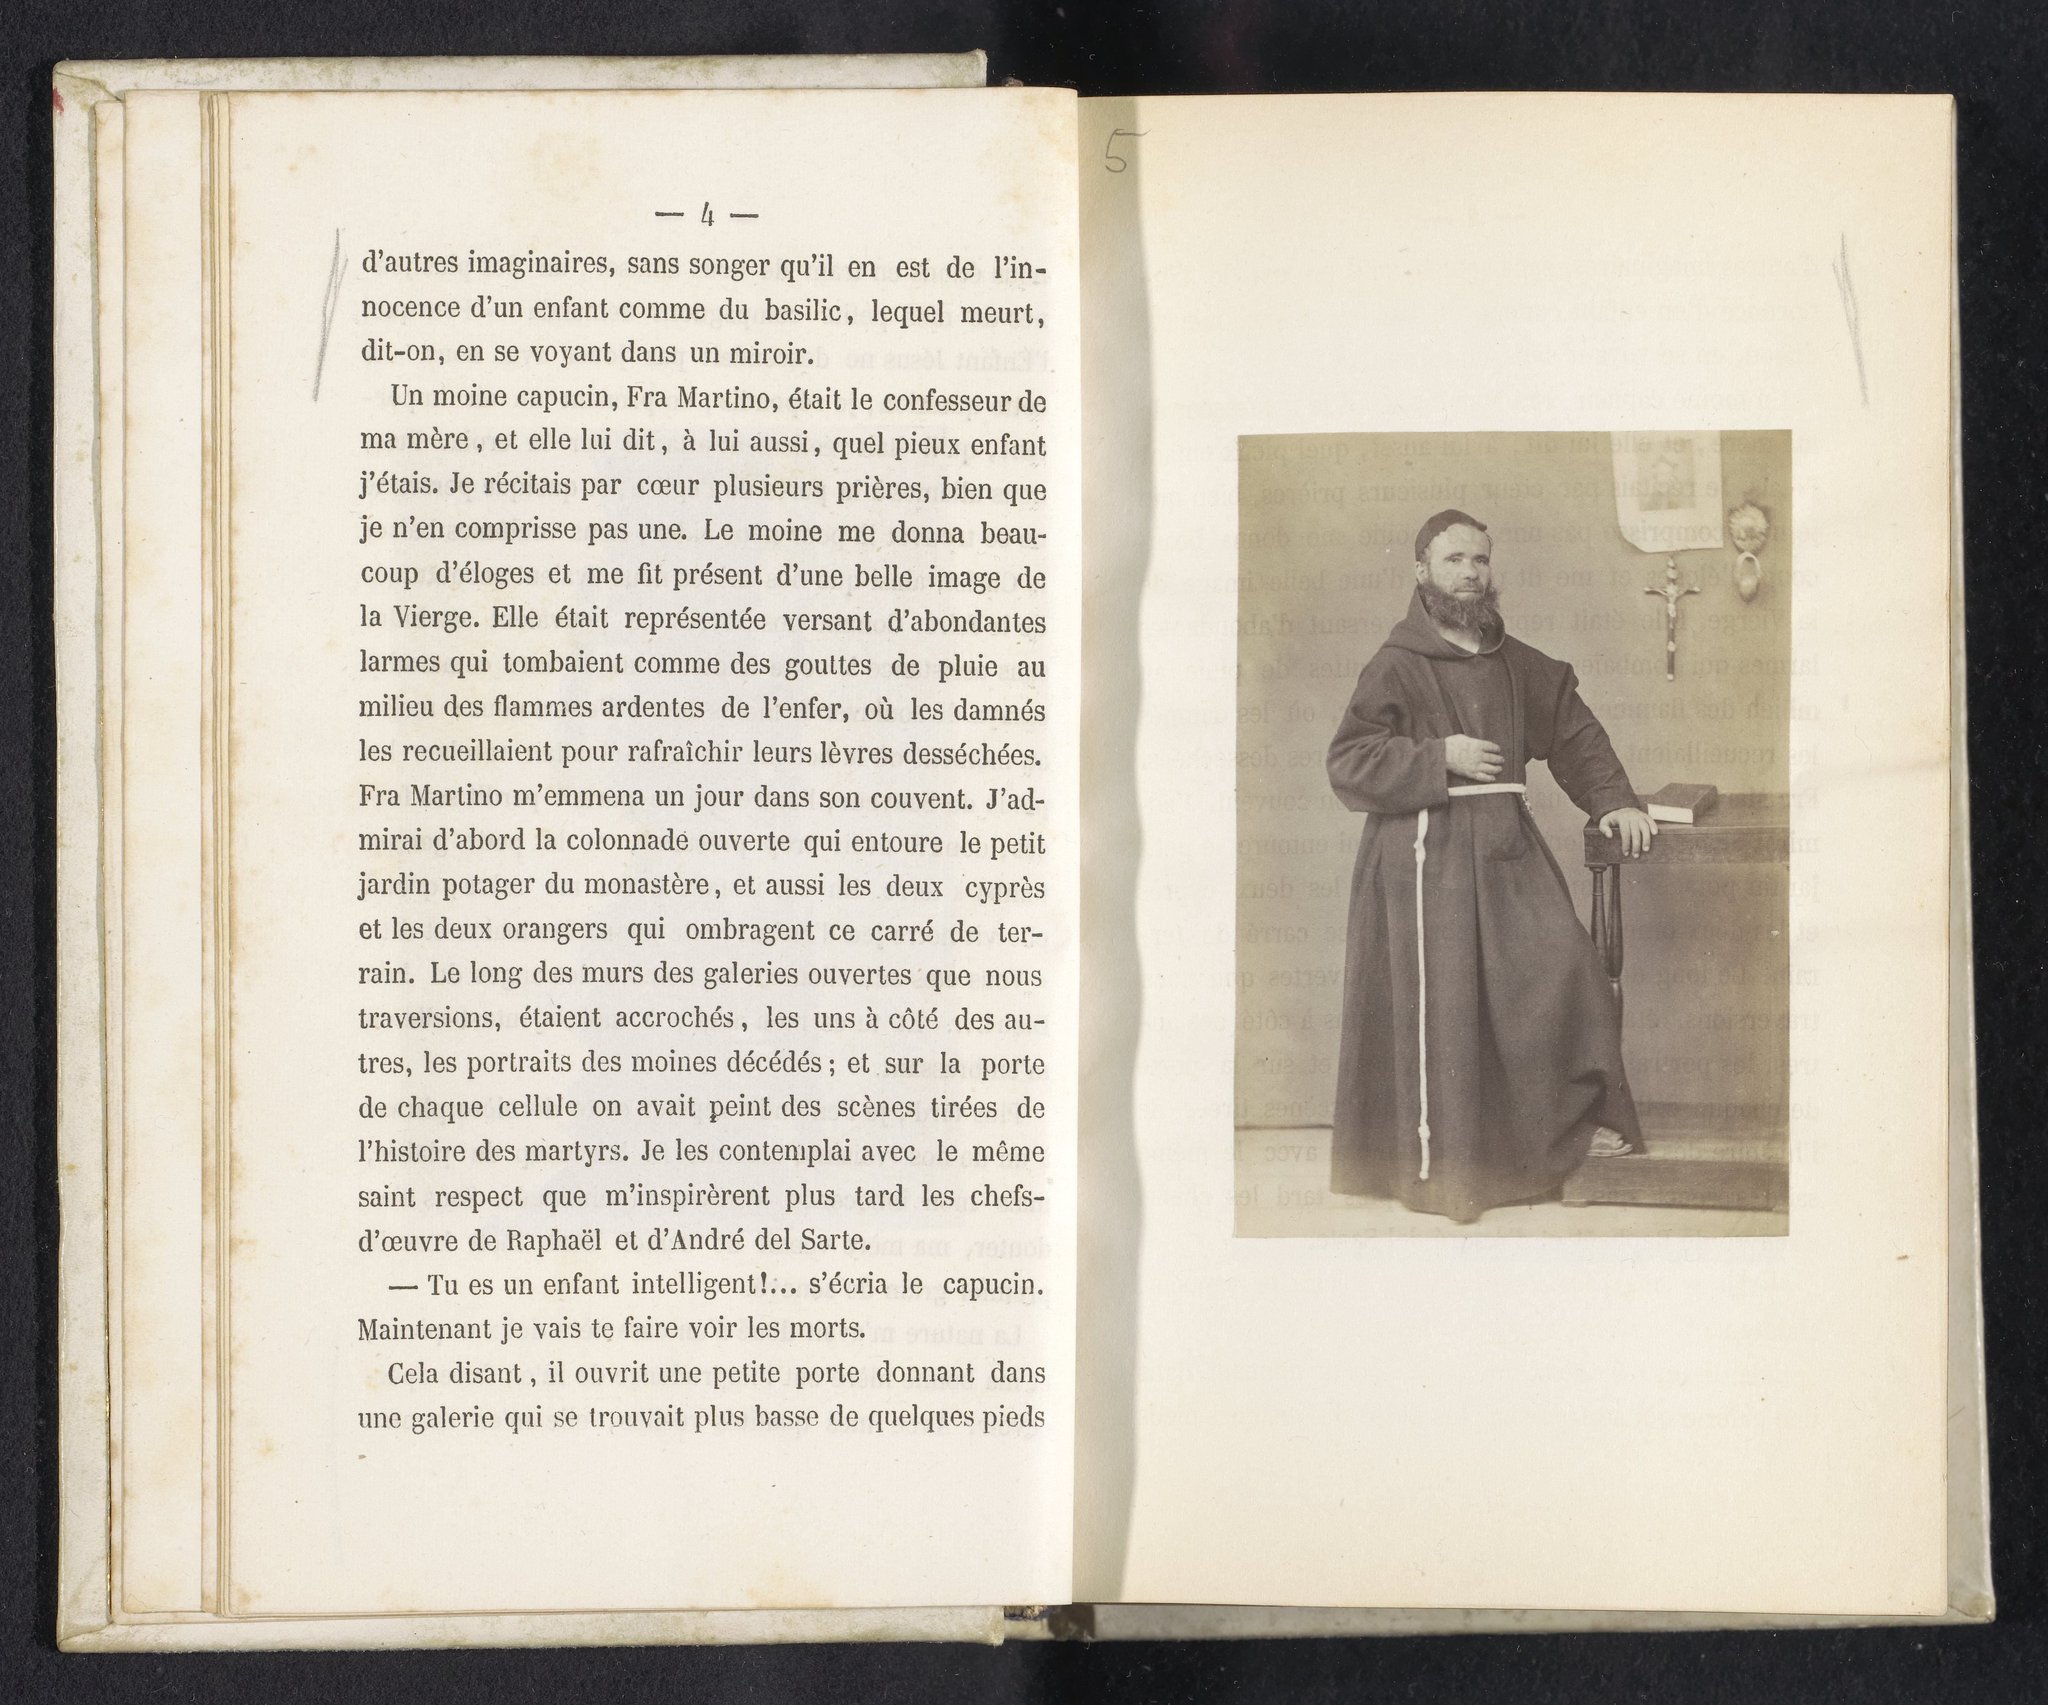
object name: photograph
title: Franciscaner monnik in een interieur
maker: Anonymous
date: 1850-1860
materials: photographic support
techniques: albumen print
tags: monk(s), friar(s), monastic orders, monastic life: franciscans, interior ~ representation of a building